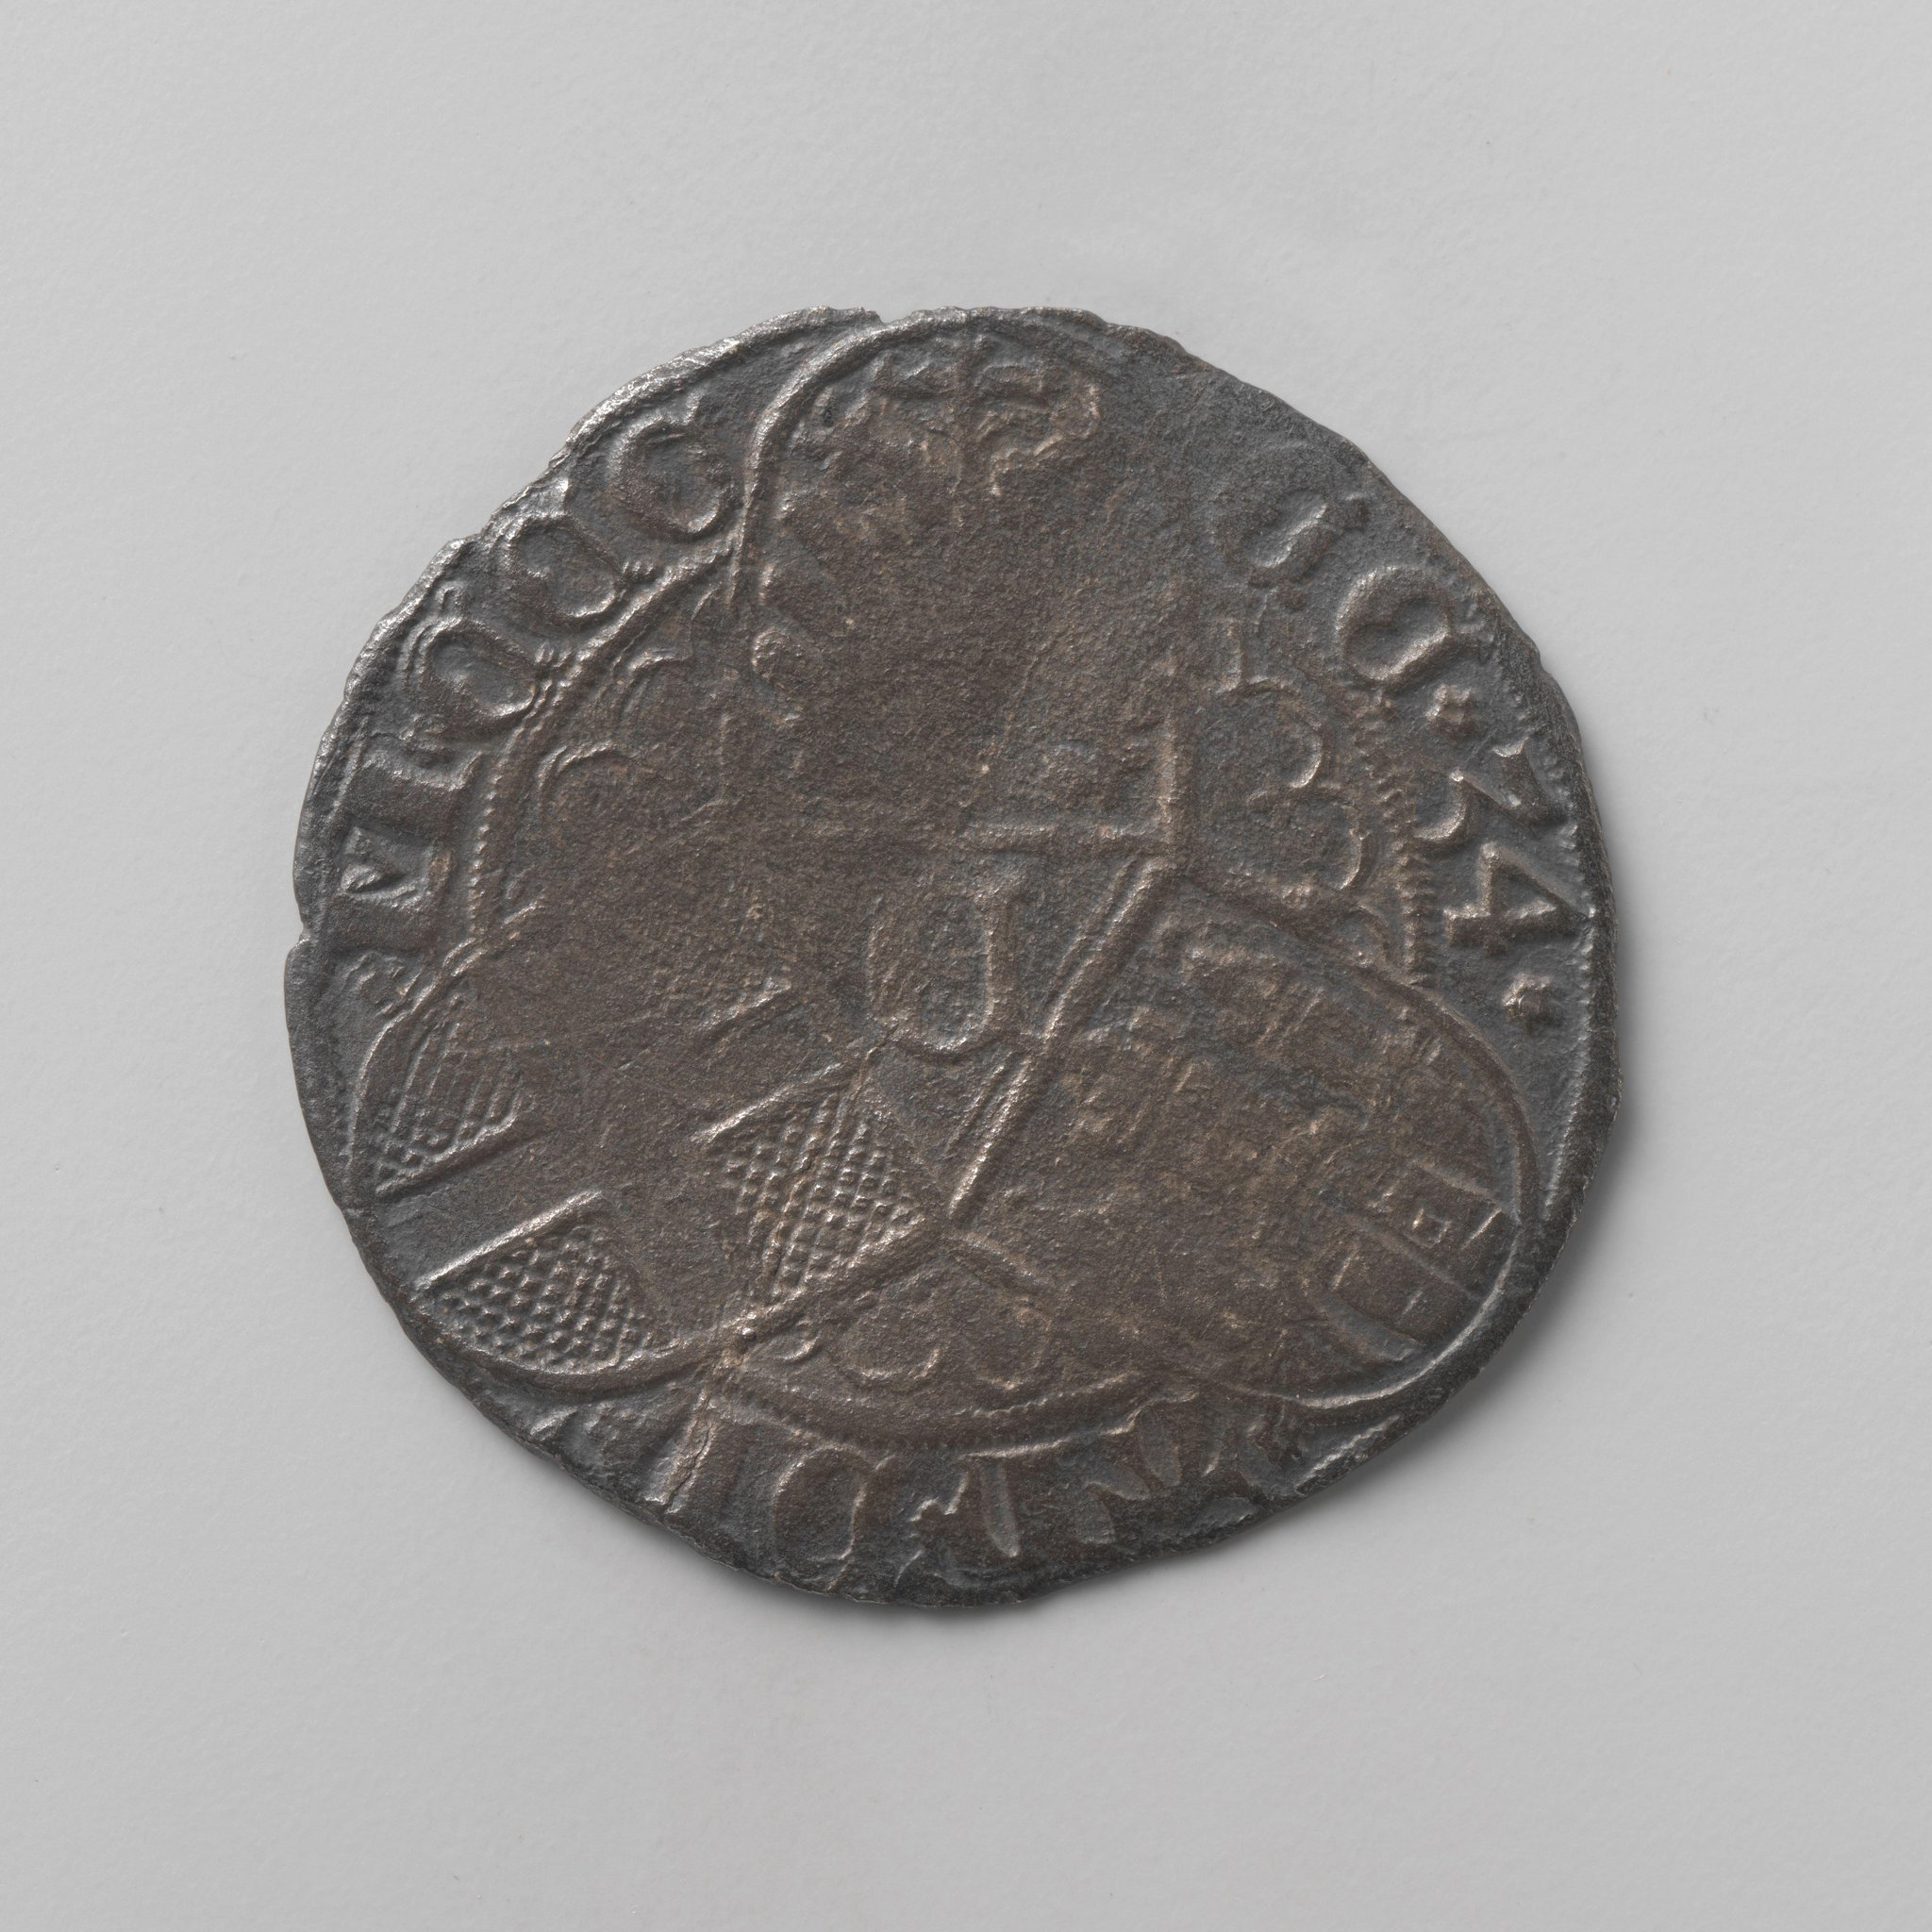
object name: coin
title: Dubbele gosseler van de Drie Steden, 1534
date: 1534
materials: silver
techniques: striking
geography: deventer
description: Zilveren munt. Voorzijde: wapenschild van Deventer op lang gebloemd kruis. Keerzijde: wapenschilden van de Drie Steden, in het centrum letter D. Jaartal in omschrift.